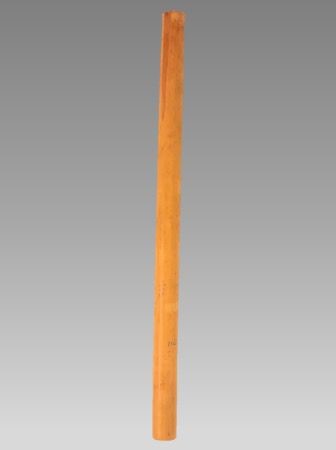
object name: pupa galanga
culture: melanesian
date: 1867-1900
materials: bamboo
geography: solomon islands